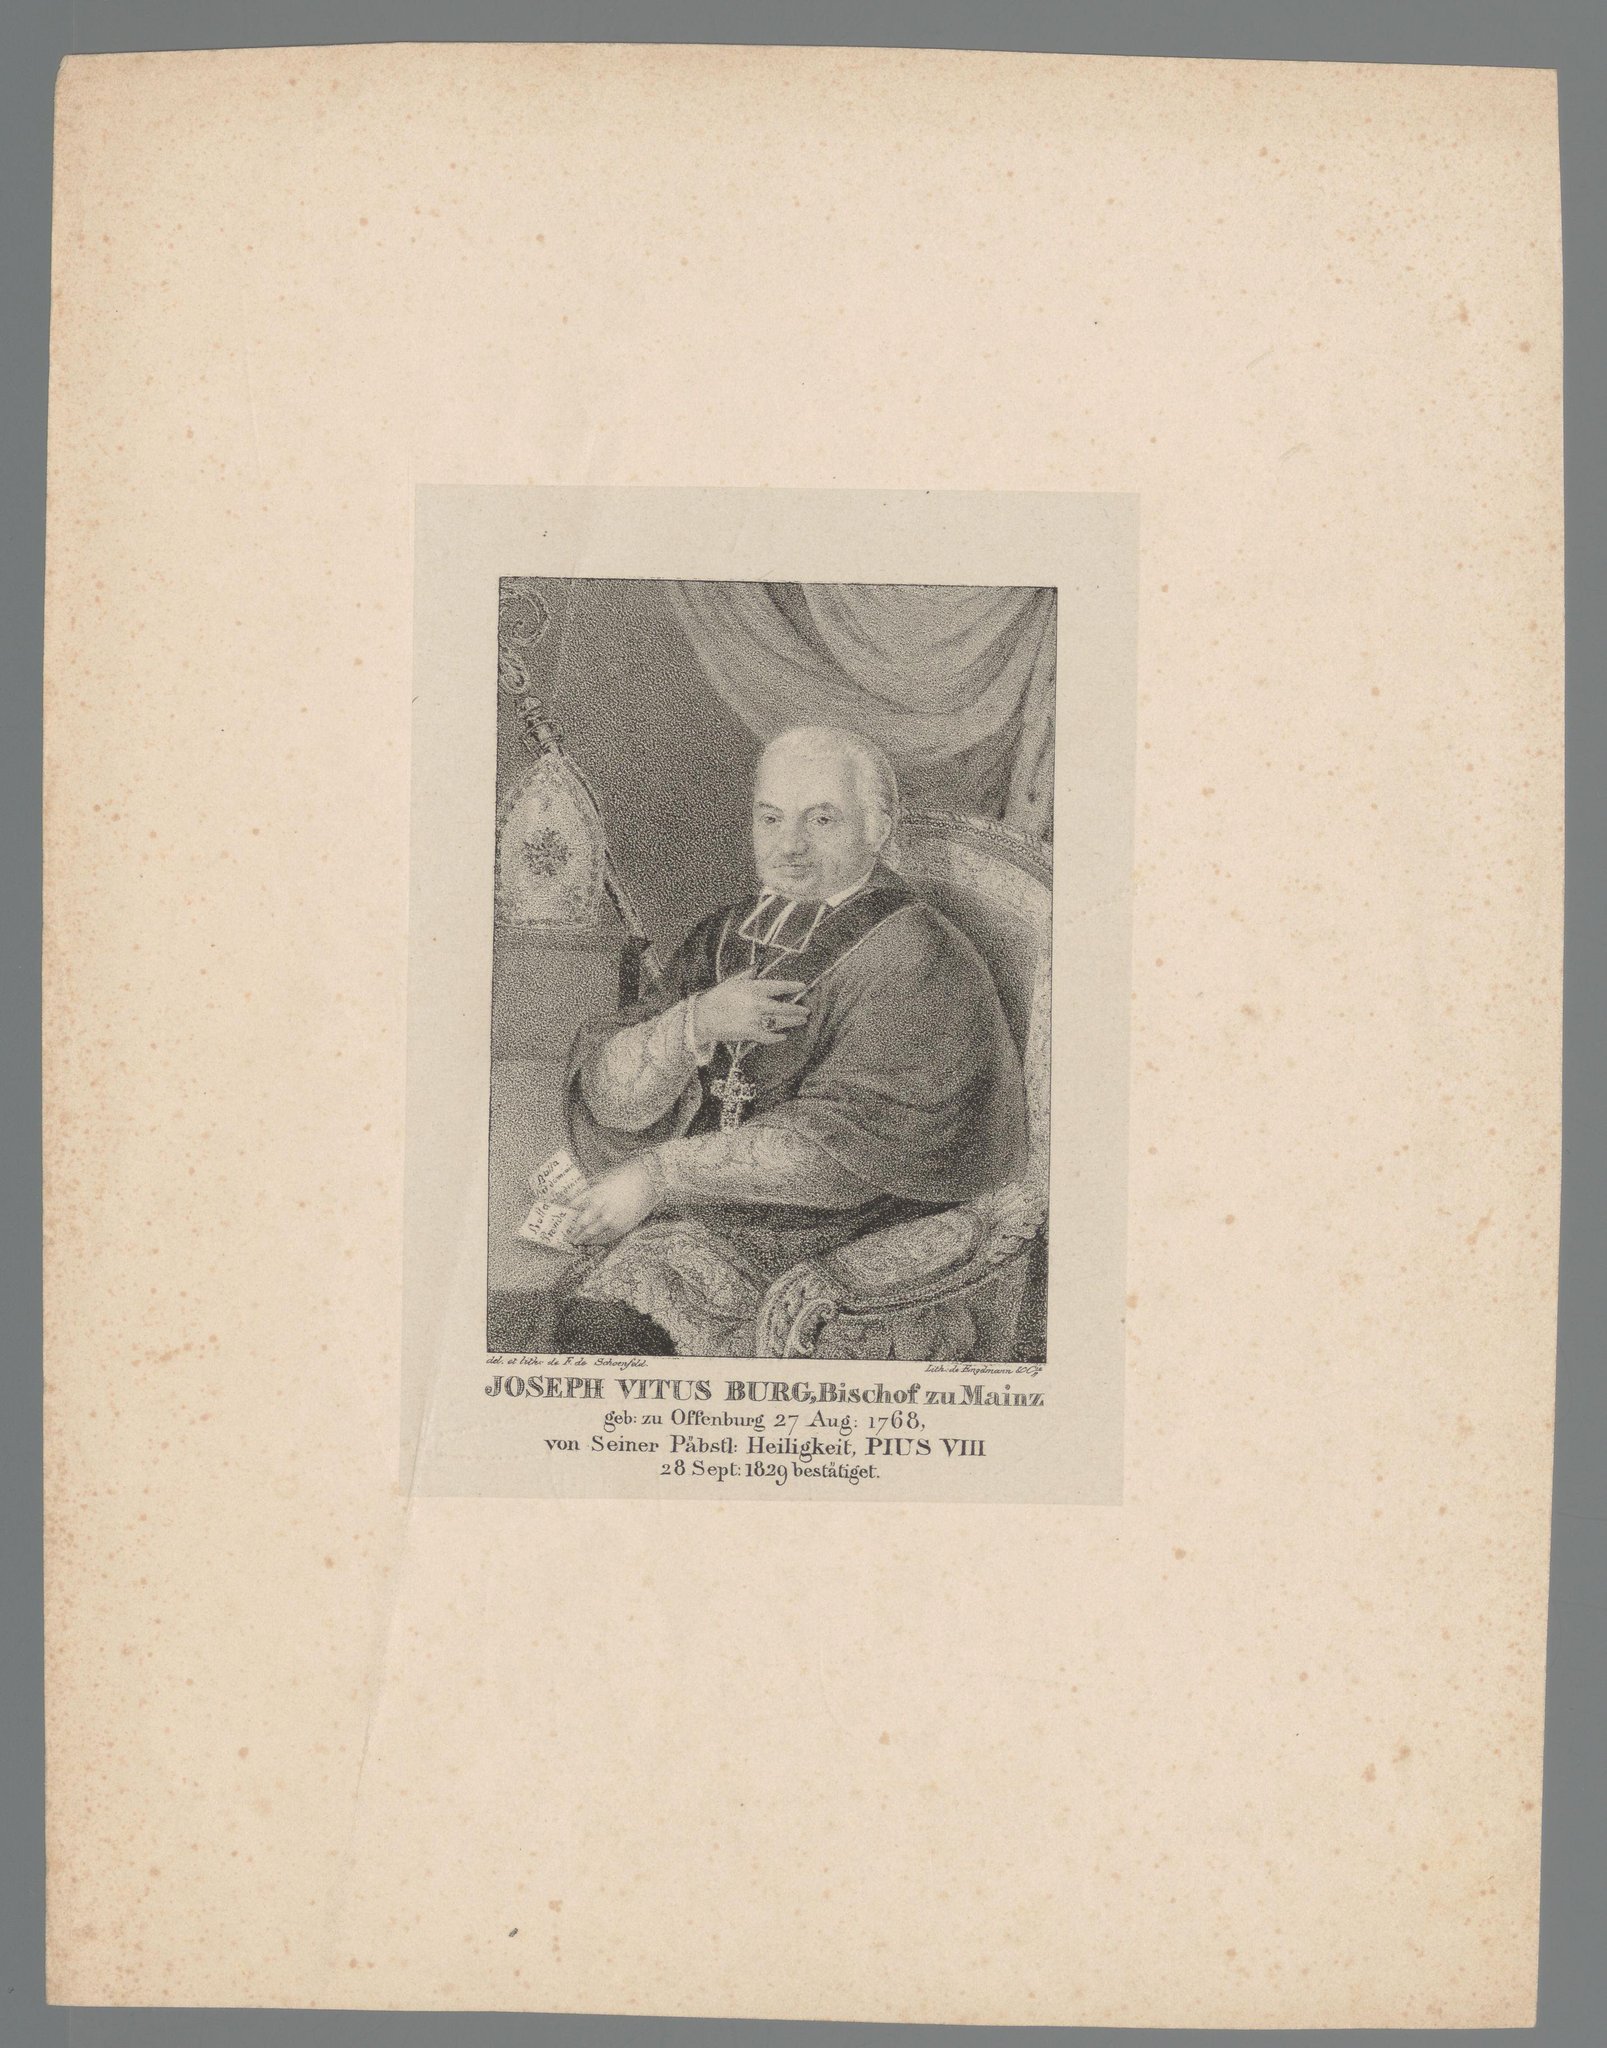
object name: print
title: Portret van Joseph Vitus Burg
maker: f. de schoenfeld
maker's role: print maker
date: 1829-1833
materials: paper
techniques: lithograph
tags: clergyman, archbishop, bishop, etc. (roman catholic), historical persons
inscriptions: collector's mark: Lugt 2228